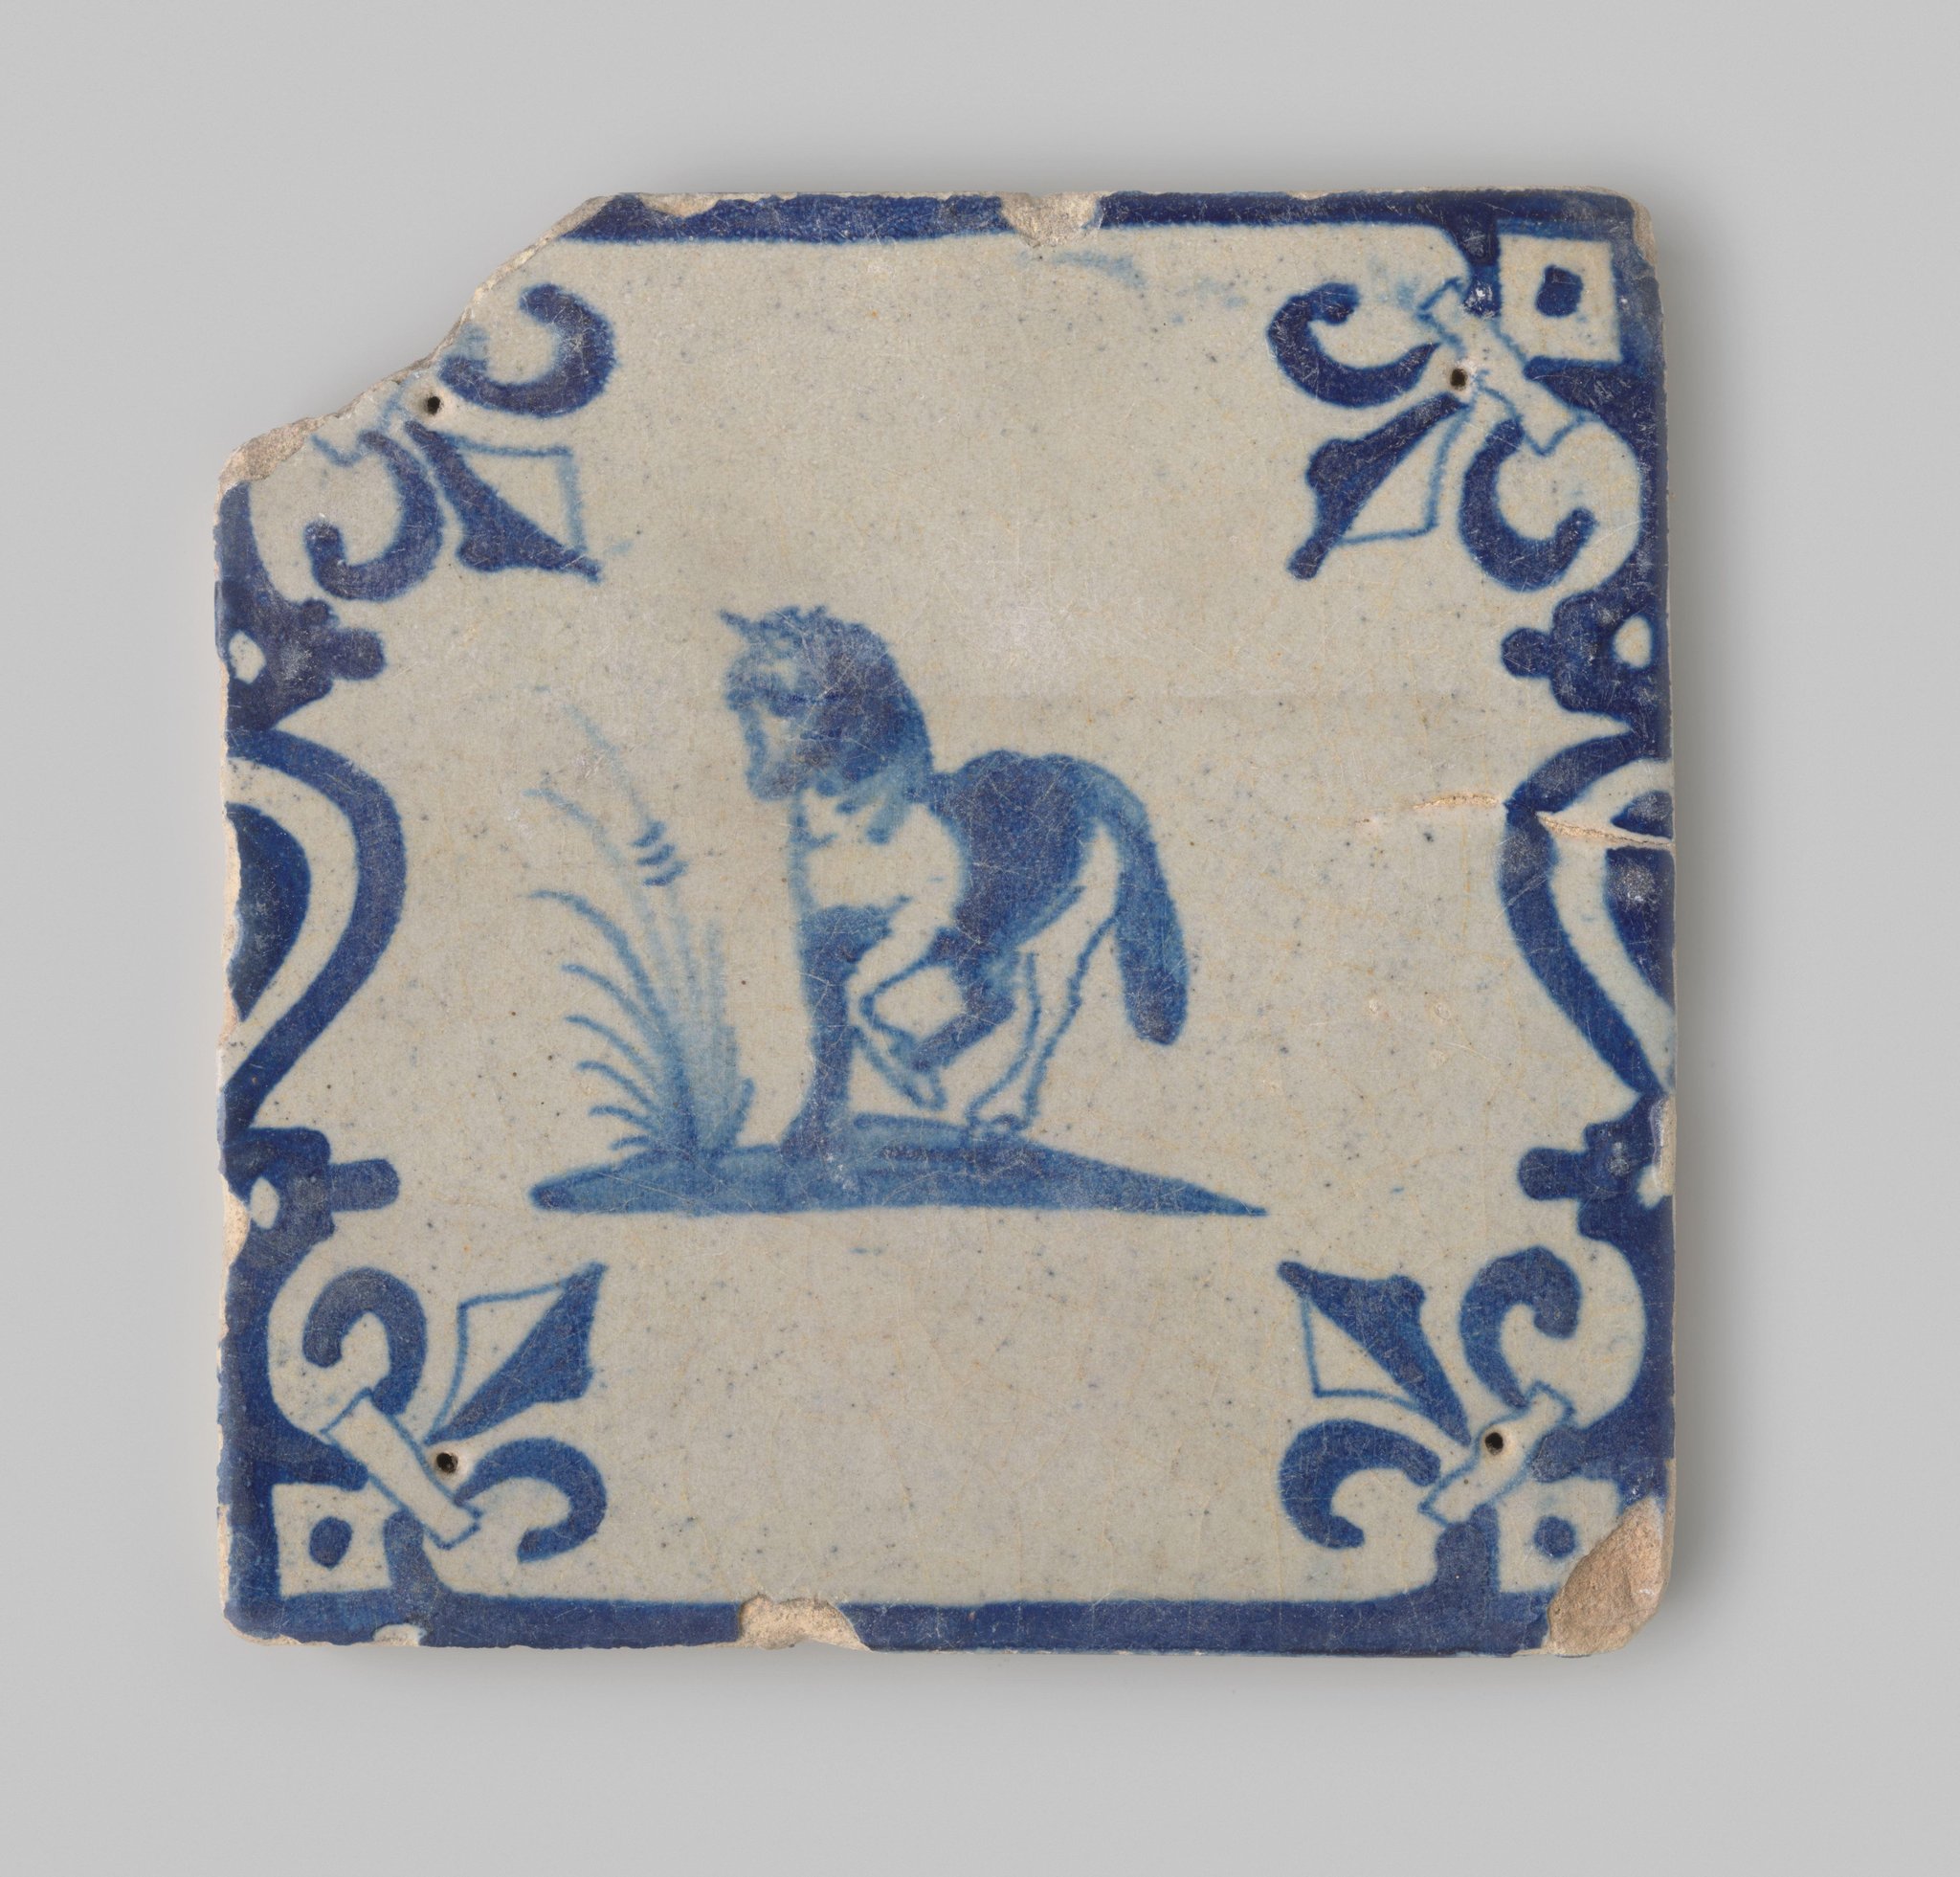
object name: fragment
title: Scherf van een tegel van geelbakkend aardewerk, voorzien van een schildering van een paard en een rand van geometrische vormen in blauw op wit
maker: Anonymous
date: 1500-1699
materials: earthenware, glaze